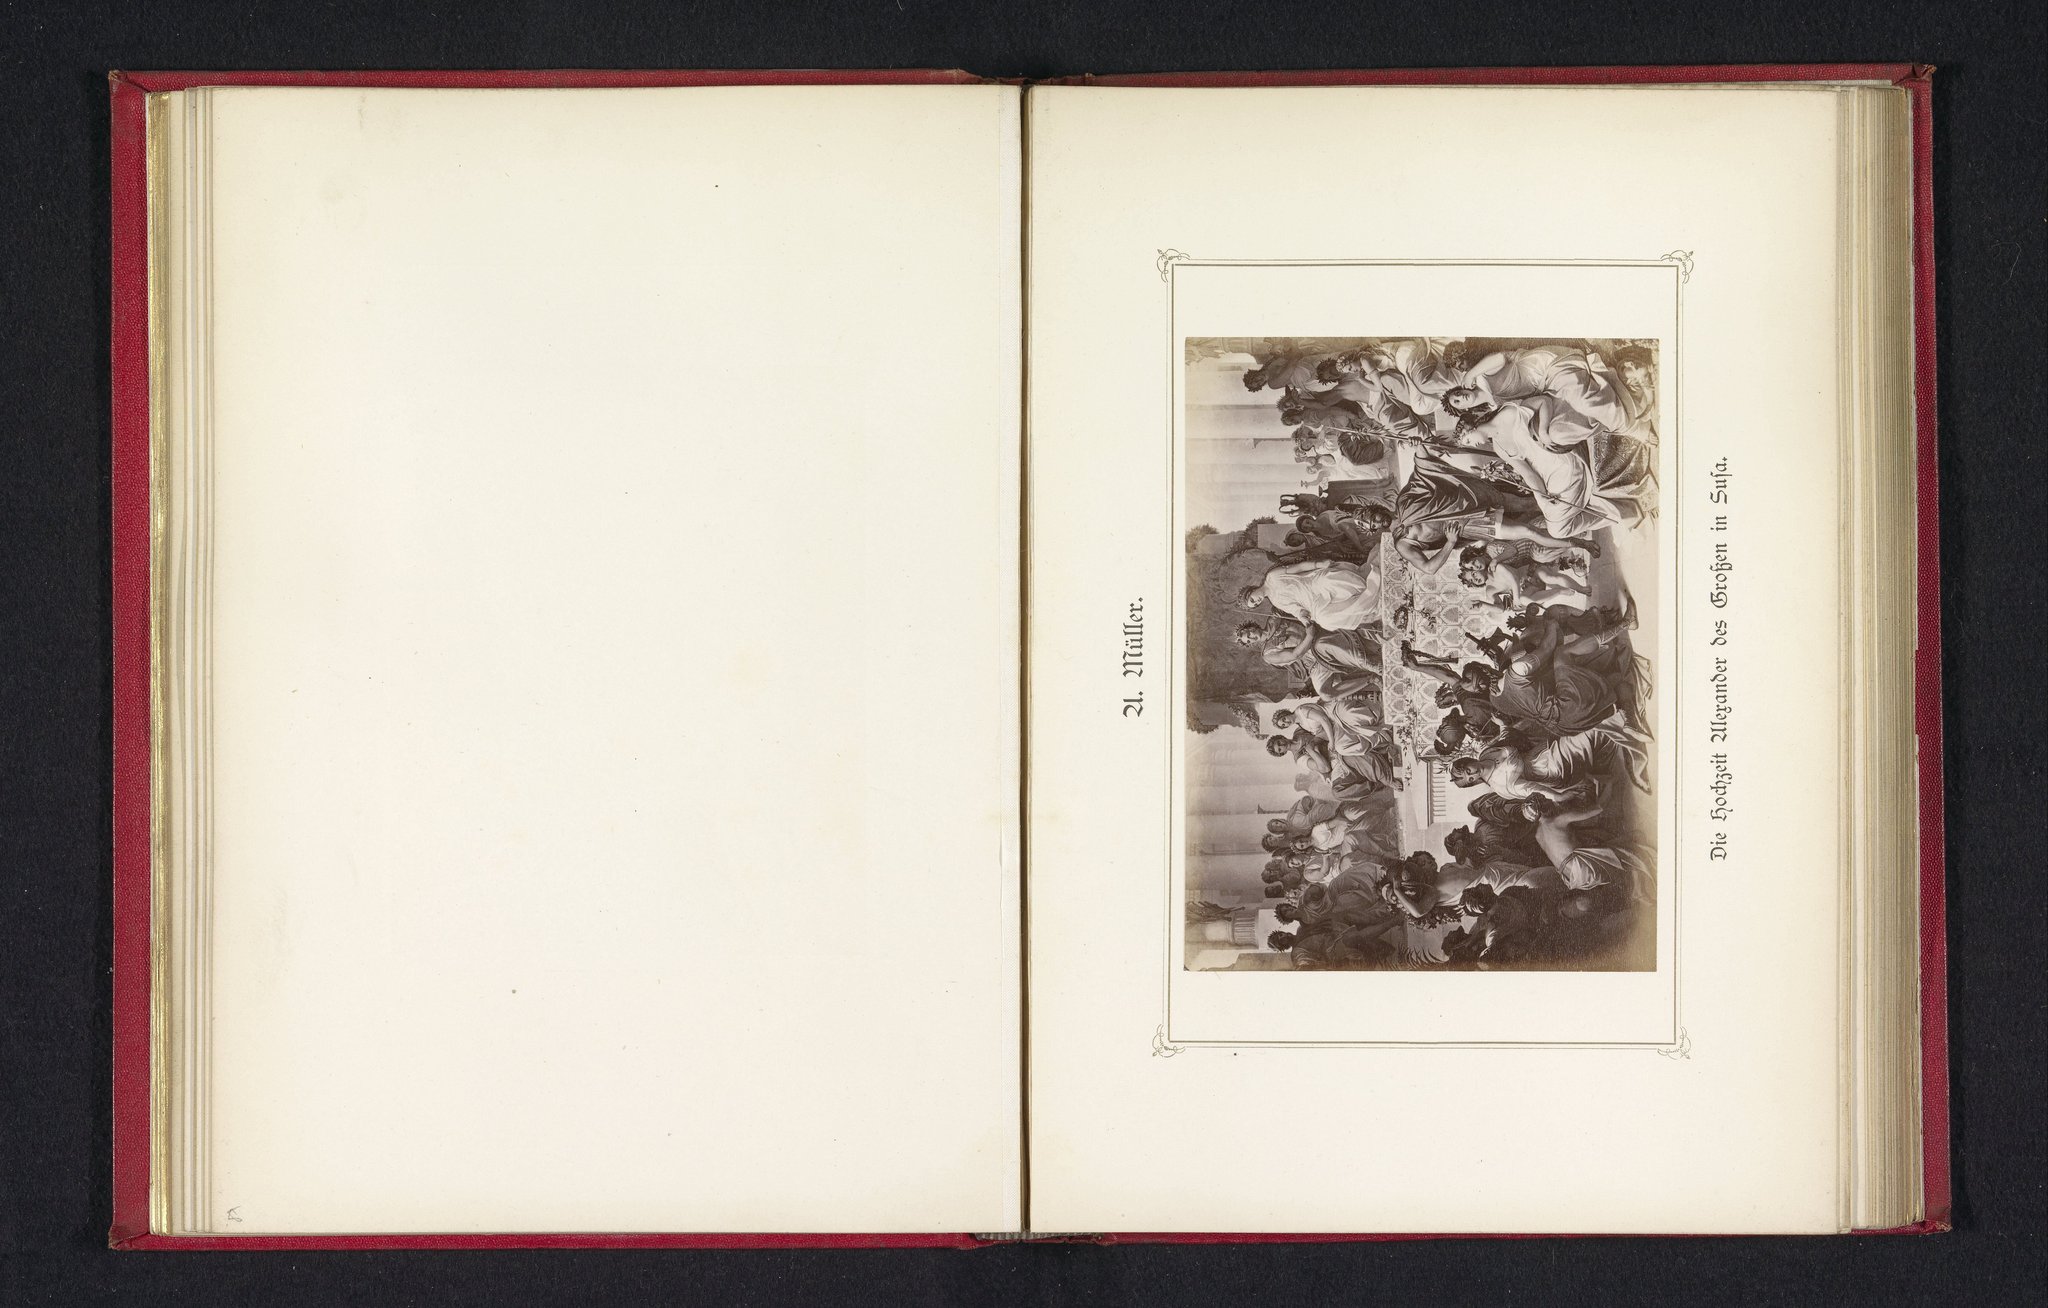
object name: page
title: Die Hochzeit Alexander des Großen in Susa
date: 1875-1880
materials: photographic support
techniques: albumen print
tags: (story of) alexander the great